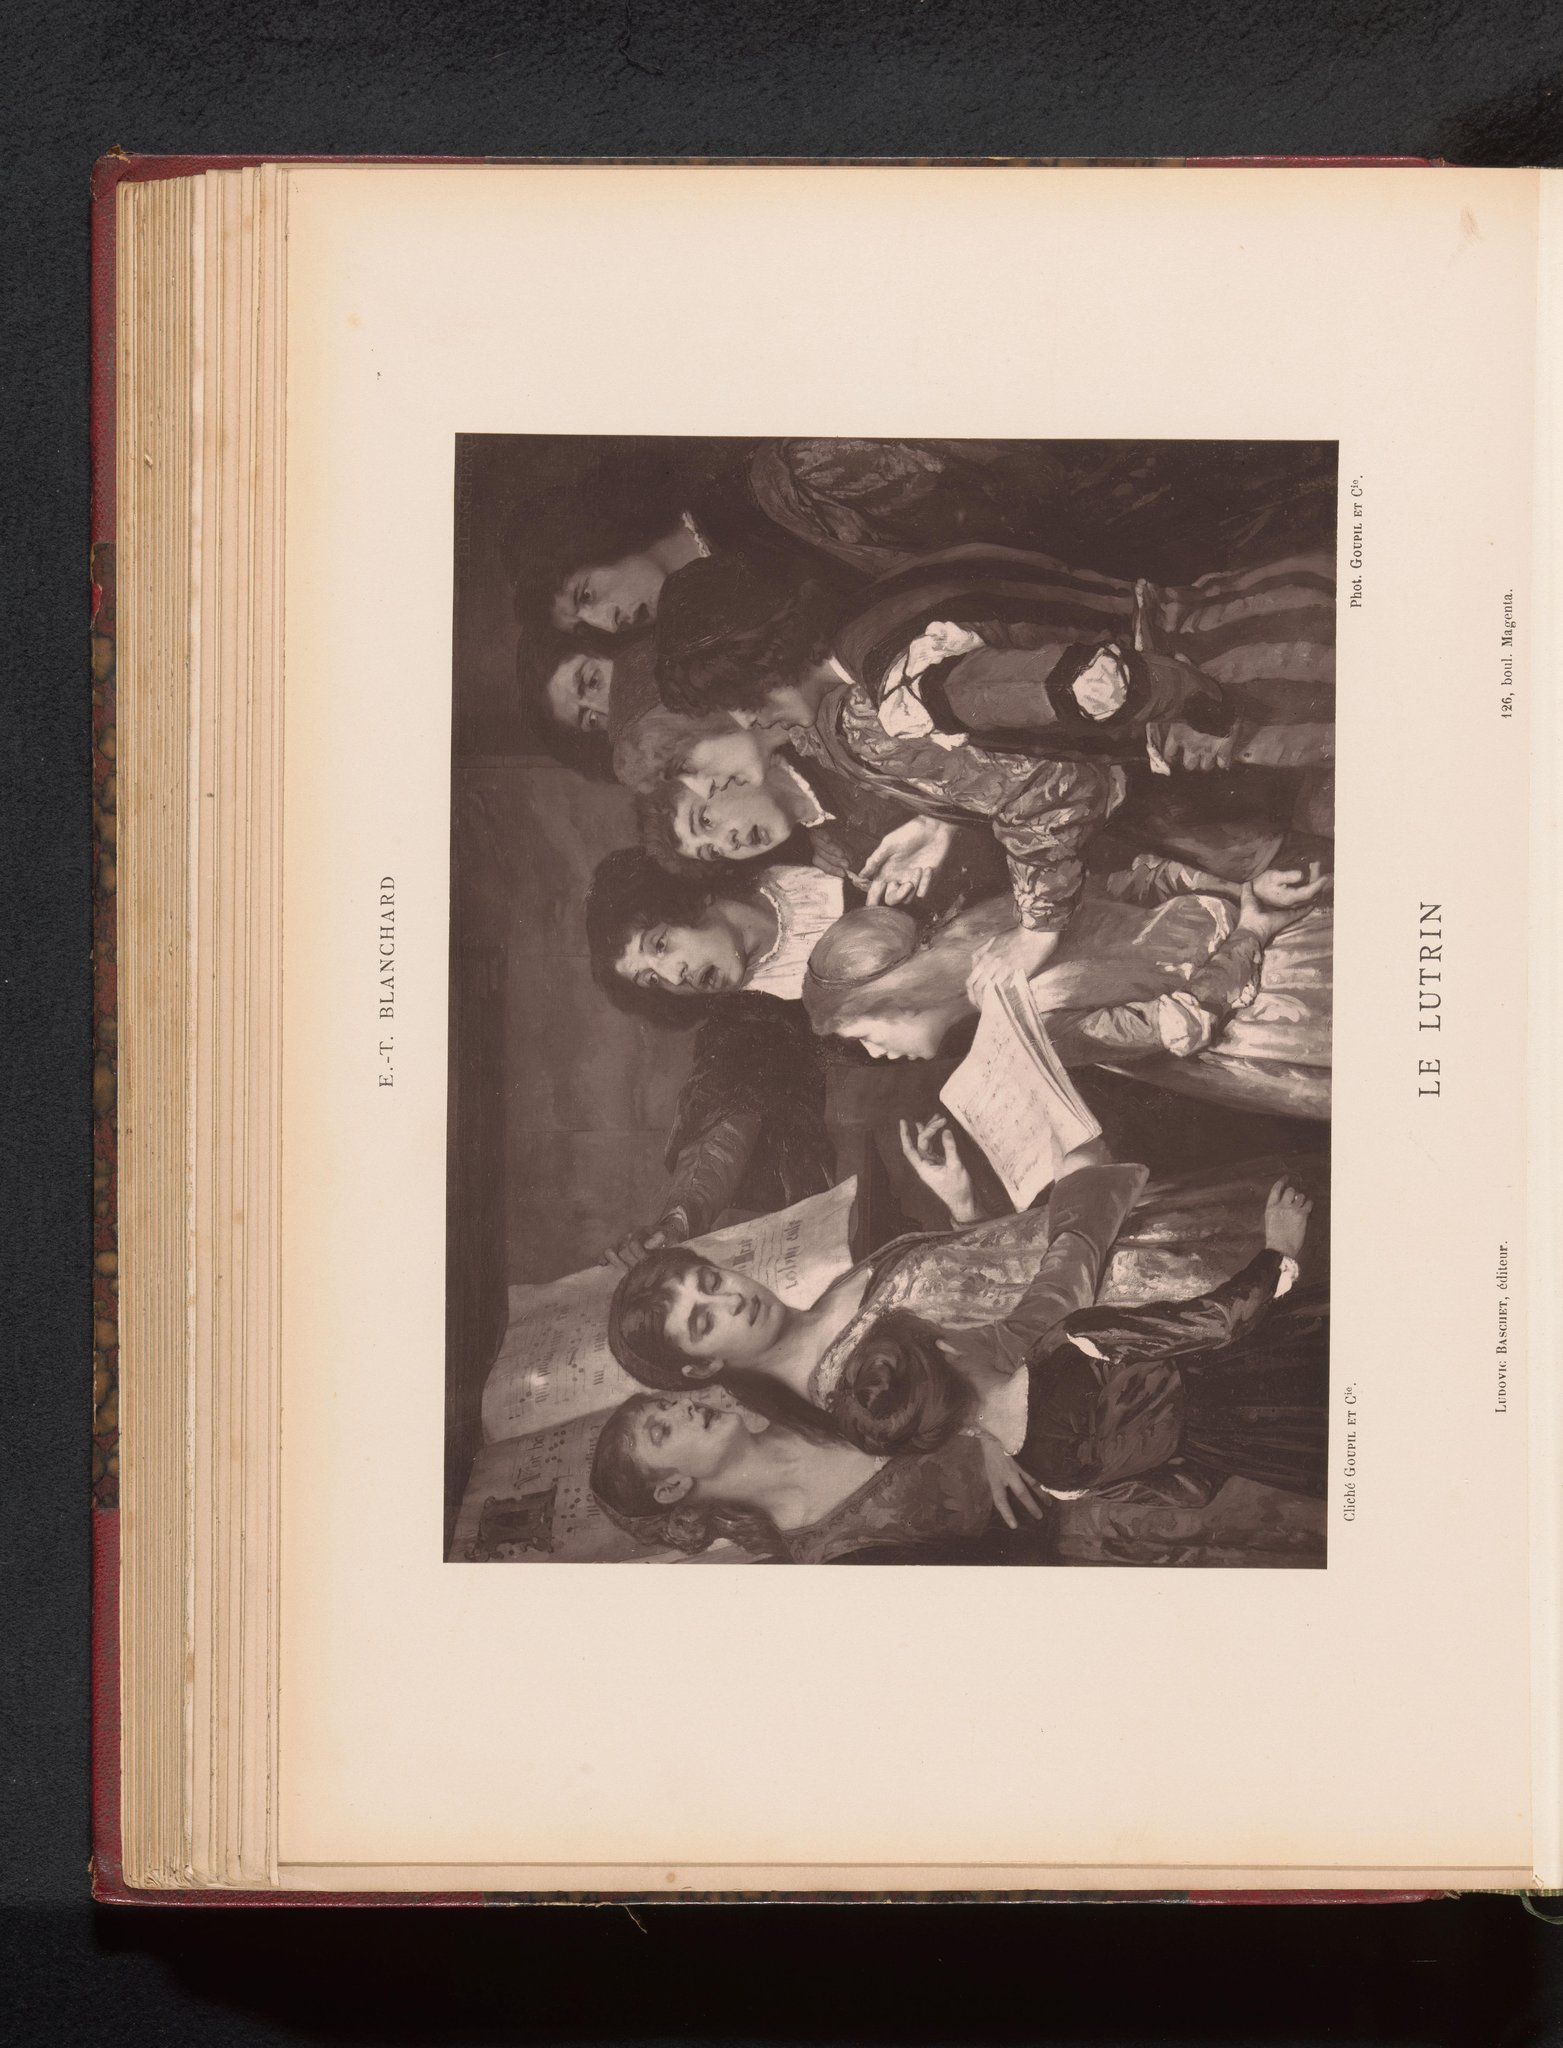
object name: reproduction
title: Le lutrin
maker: édouard-théophile blanchard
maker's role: painter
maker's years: 1844-1879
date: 1867-1880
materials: paper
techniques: woodburytype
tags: choir, painting, drawing and the graphic arts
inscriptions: inscription: ‘E.-T. Blanchard/ Ludovic Baschet, éditeur/ 126, boul. Magenta.’